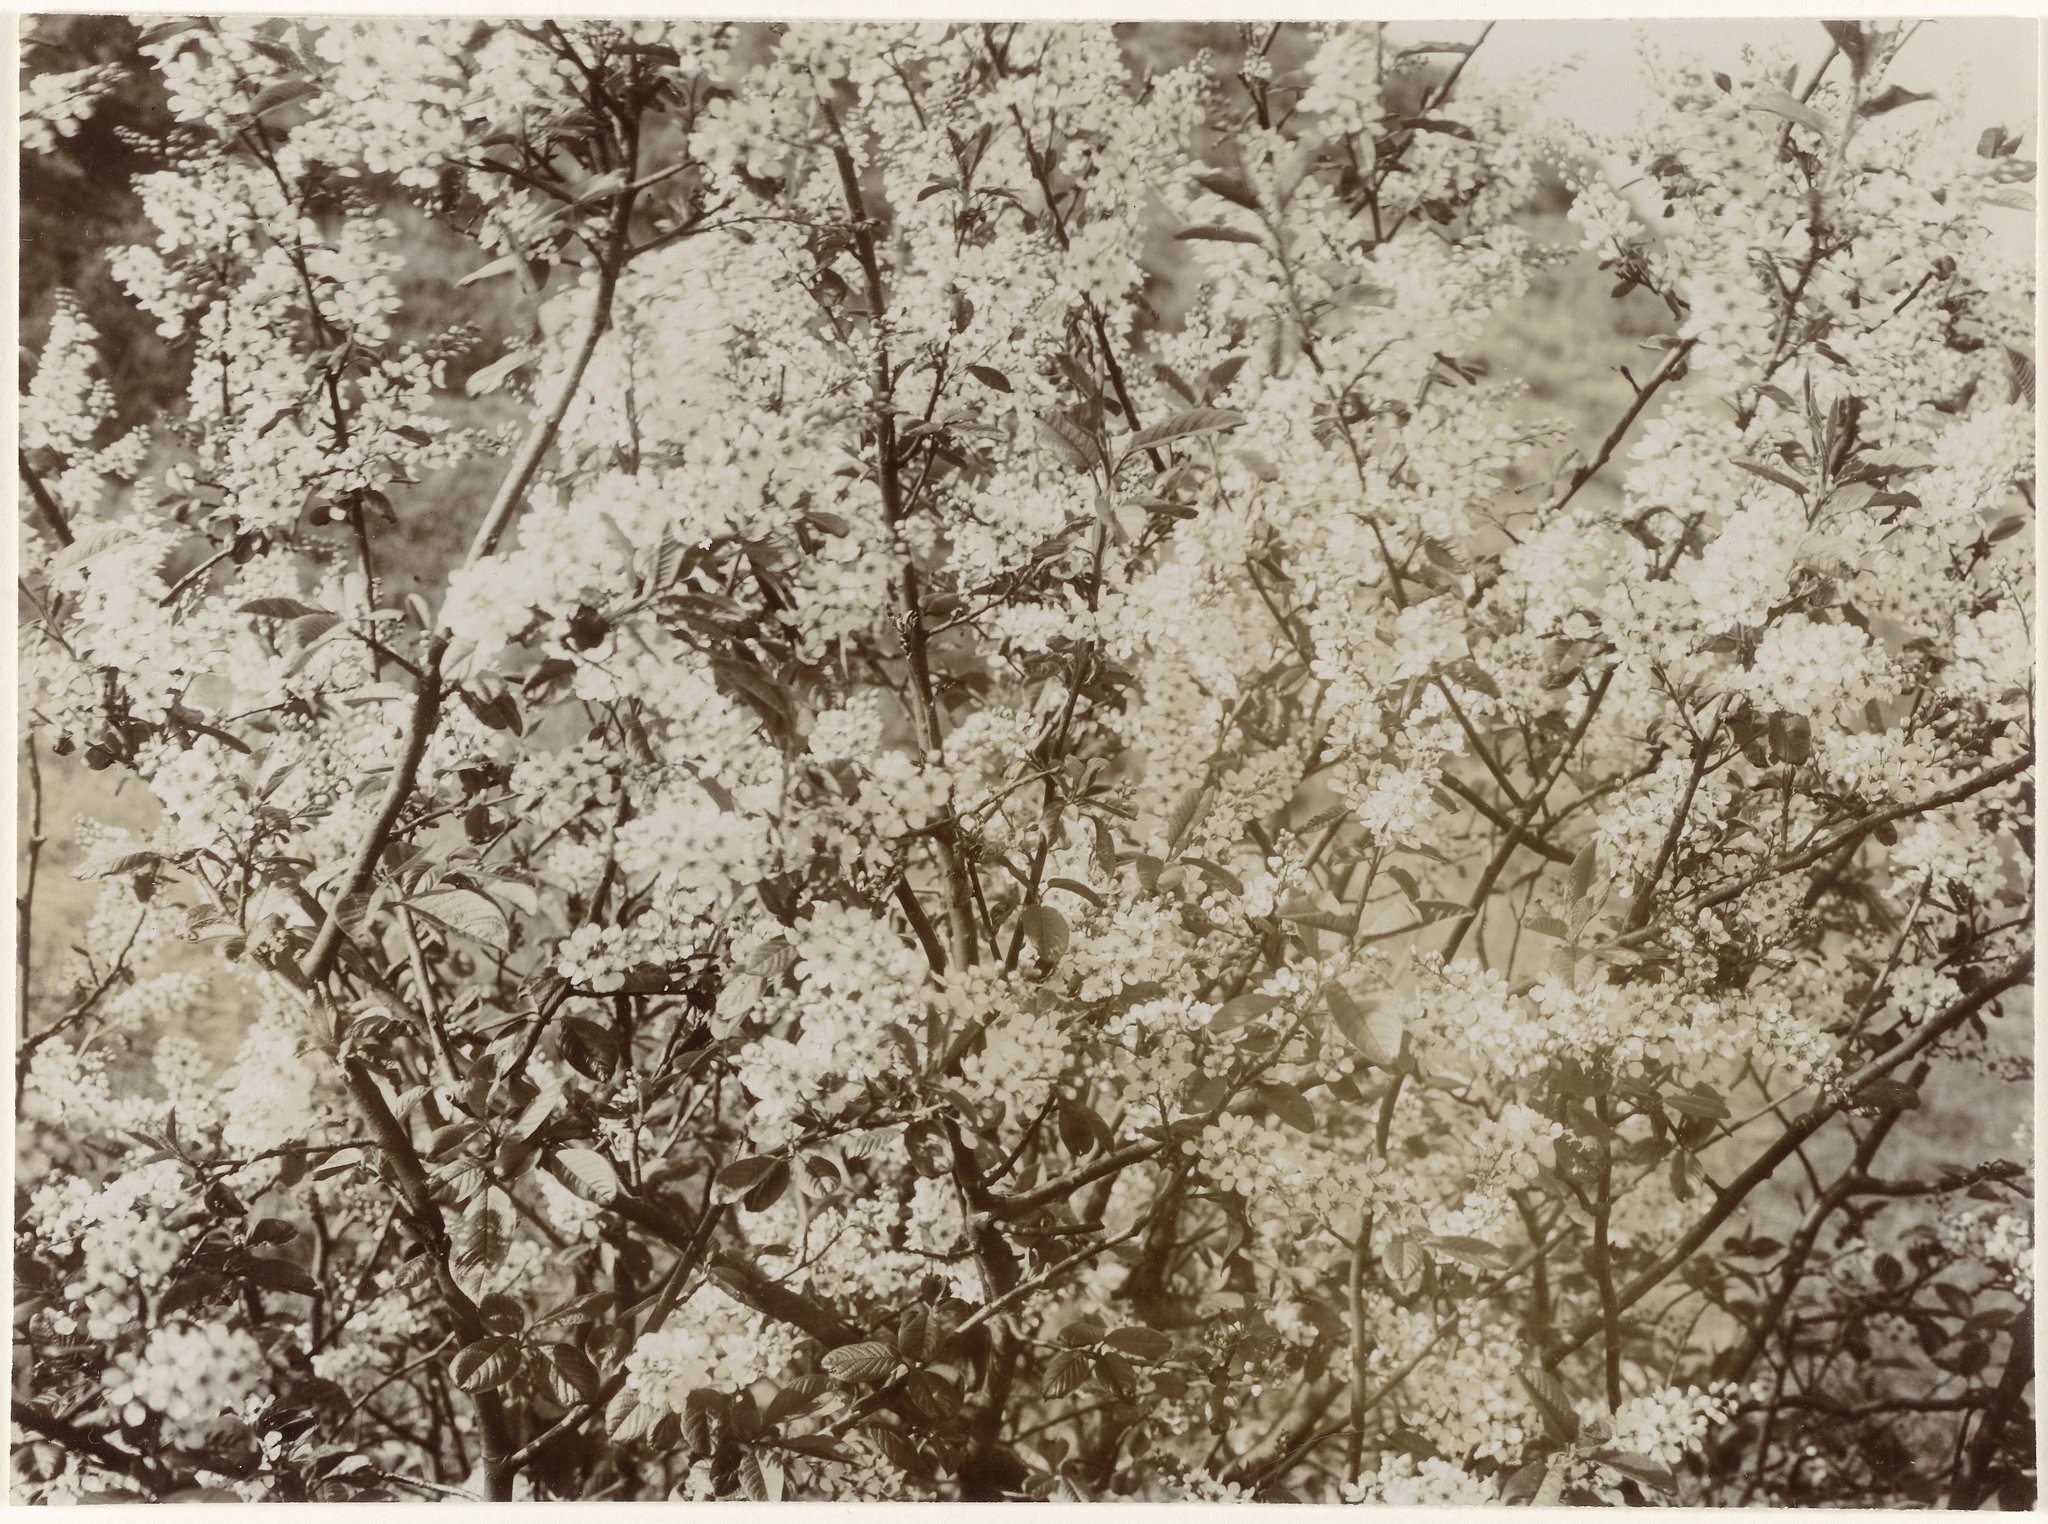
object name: photograph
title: Amandelbloesem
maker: richard tepe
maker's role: fotograaf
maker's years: 1864-1952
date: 1900-1940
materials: photographic support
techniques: gelatin silver print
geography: netherlands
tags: trees: almond-tree (flowers, blossom, blossoming)